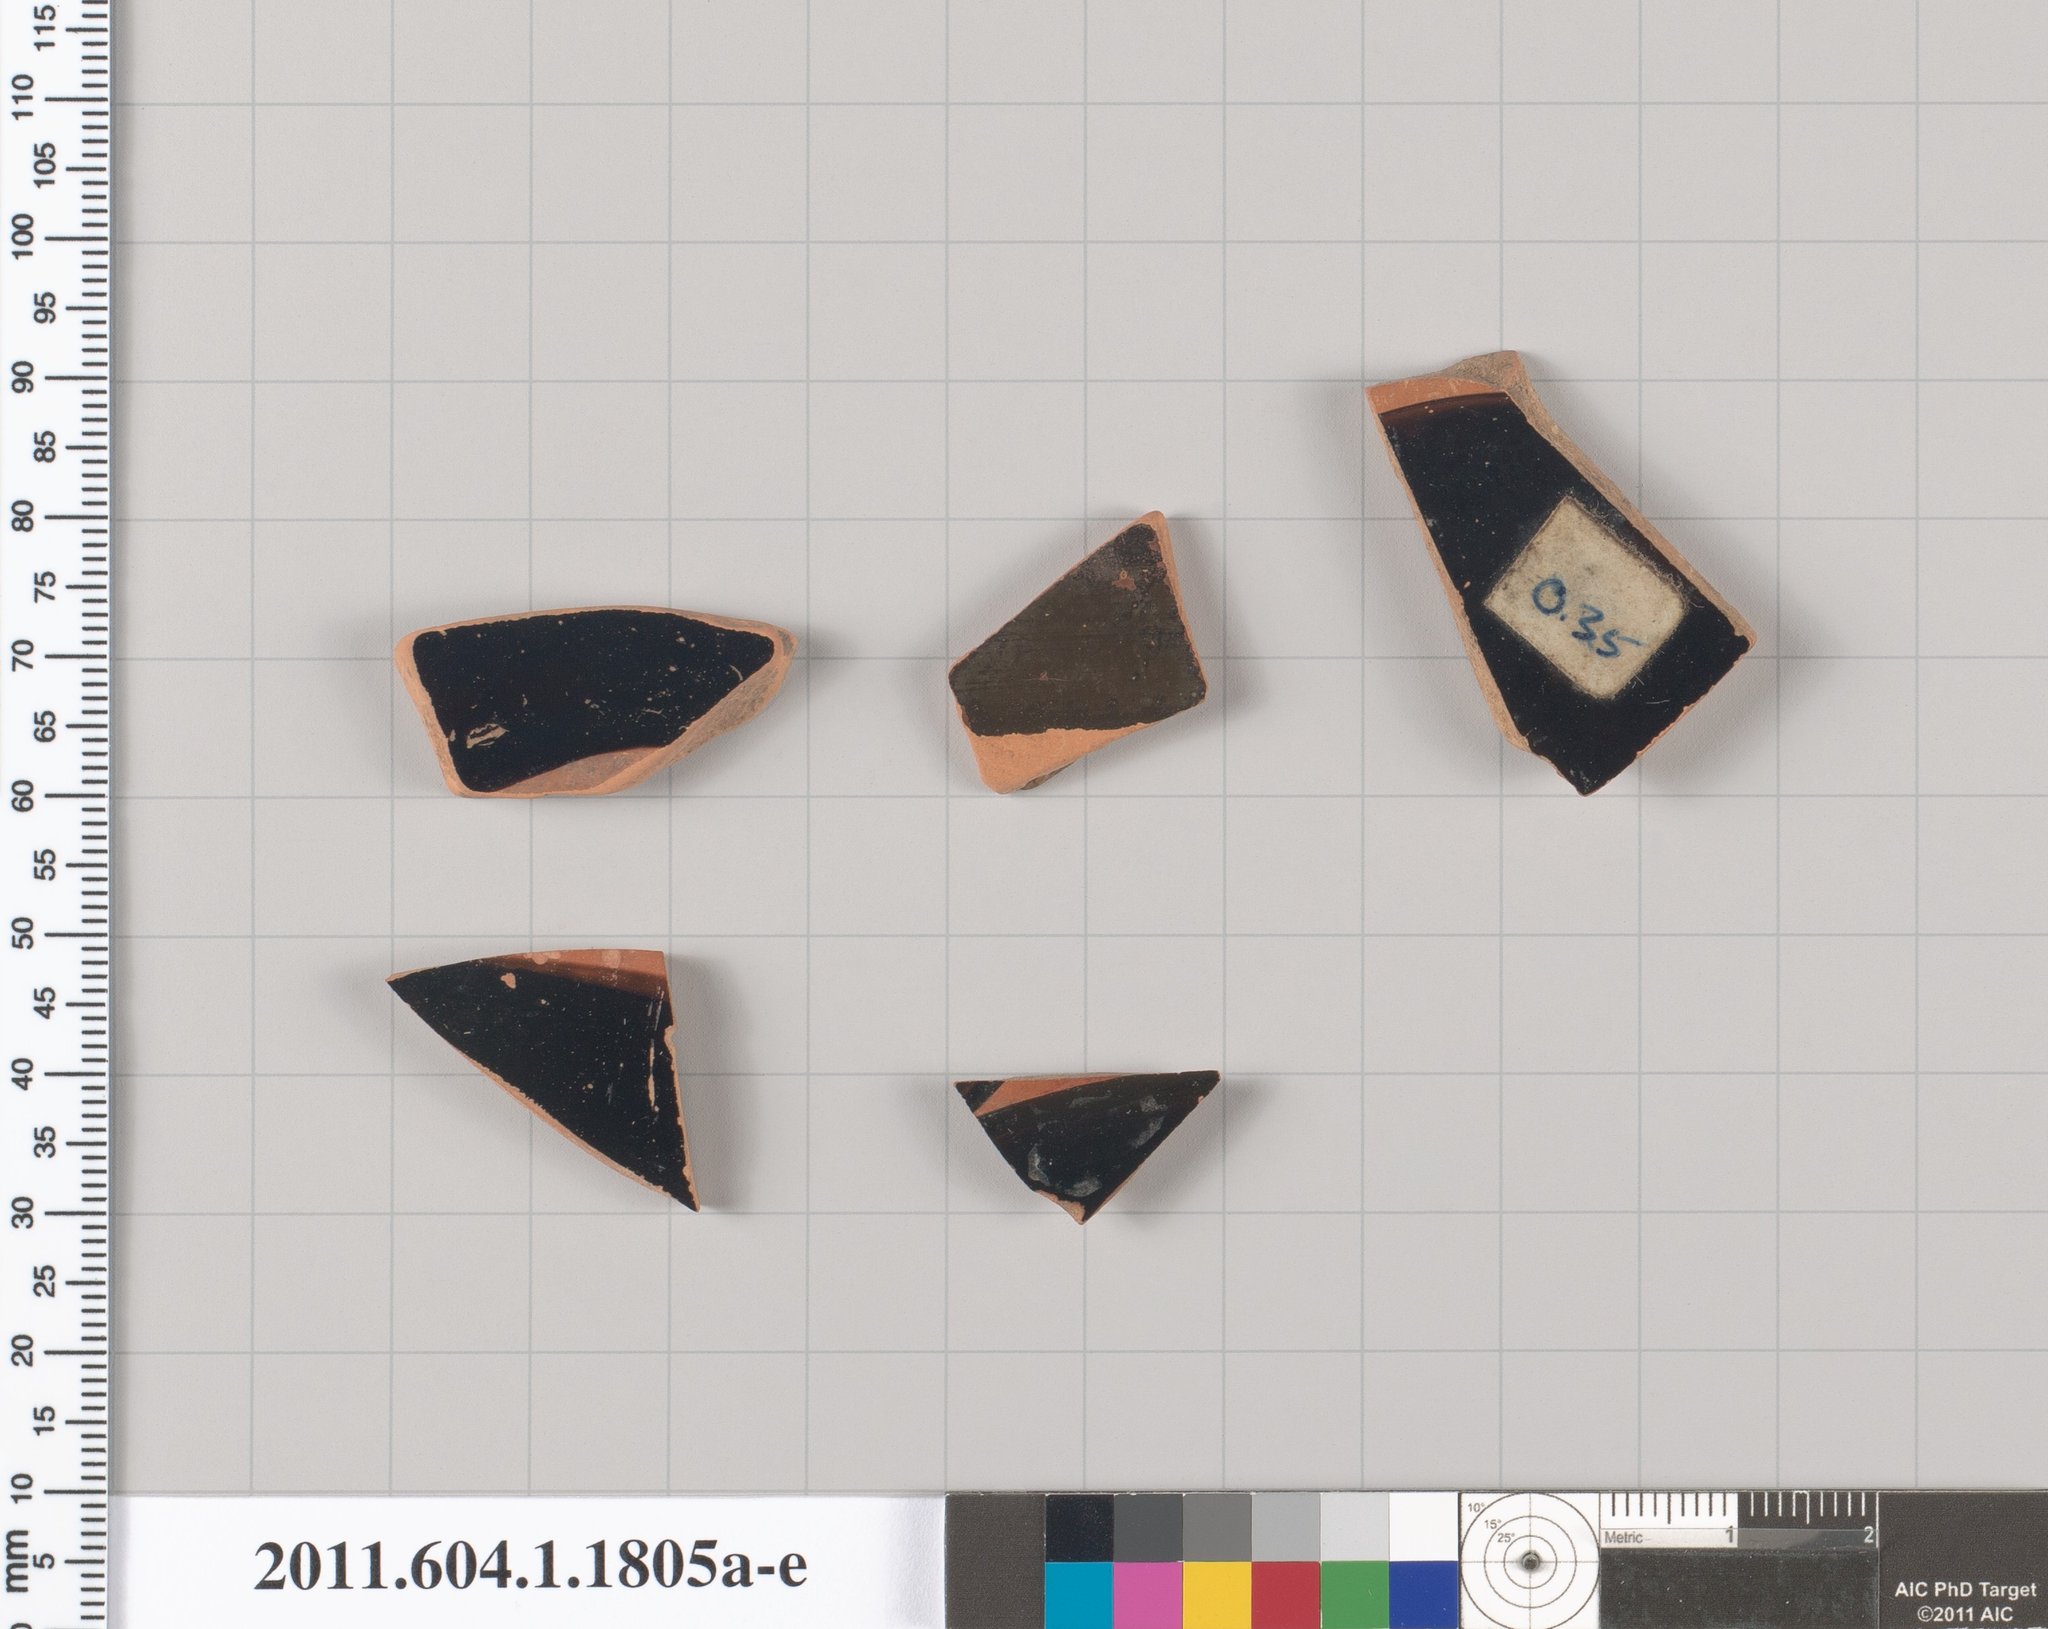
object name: kylix fragment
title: Terracotta rim fragments of kylikes(drinking cups)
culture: greek, attic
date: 500-401 BCE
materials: terracotta